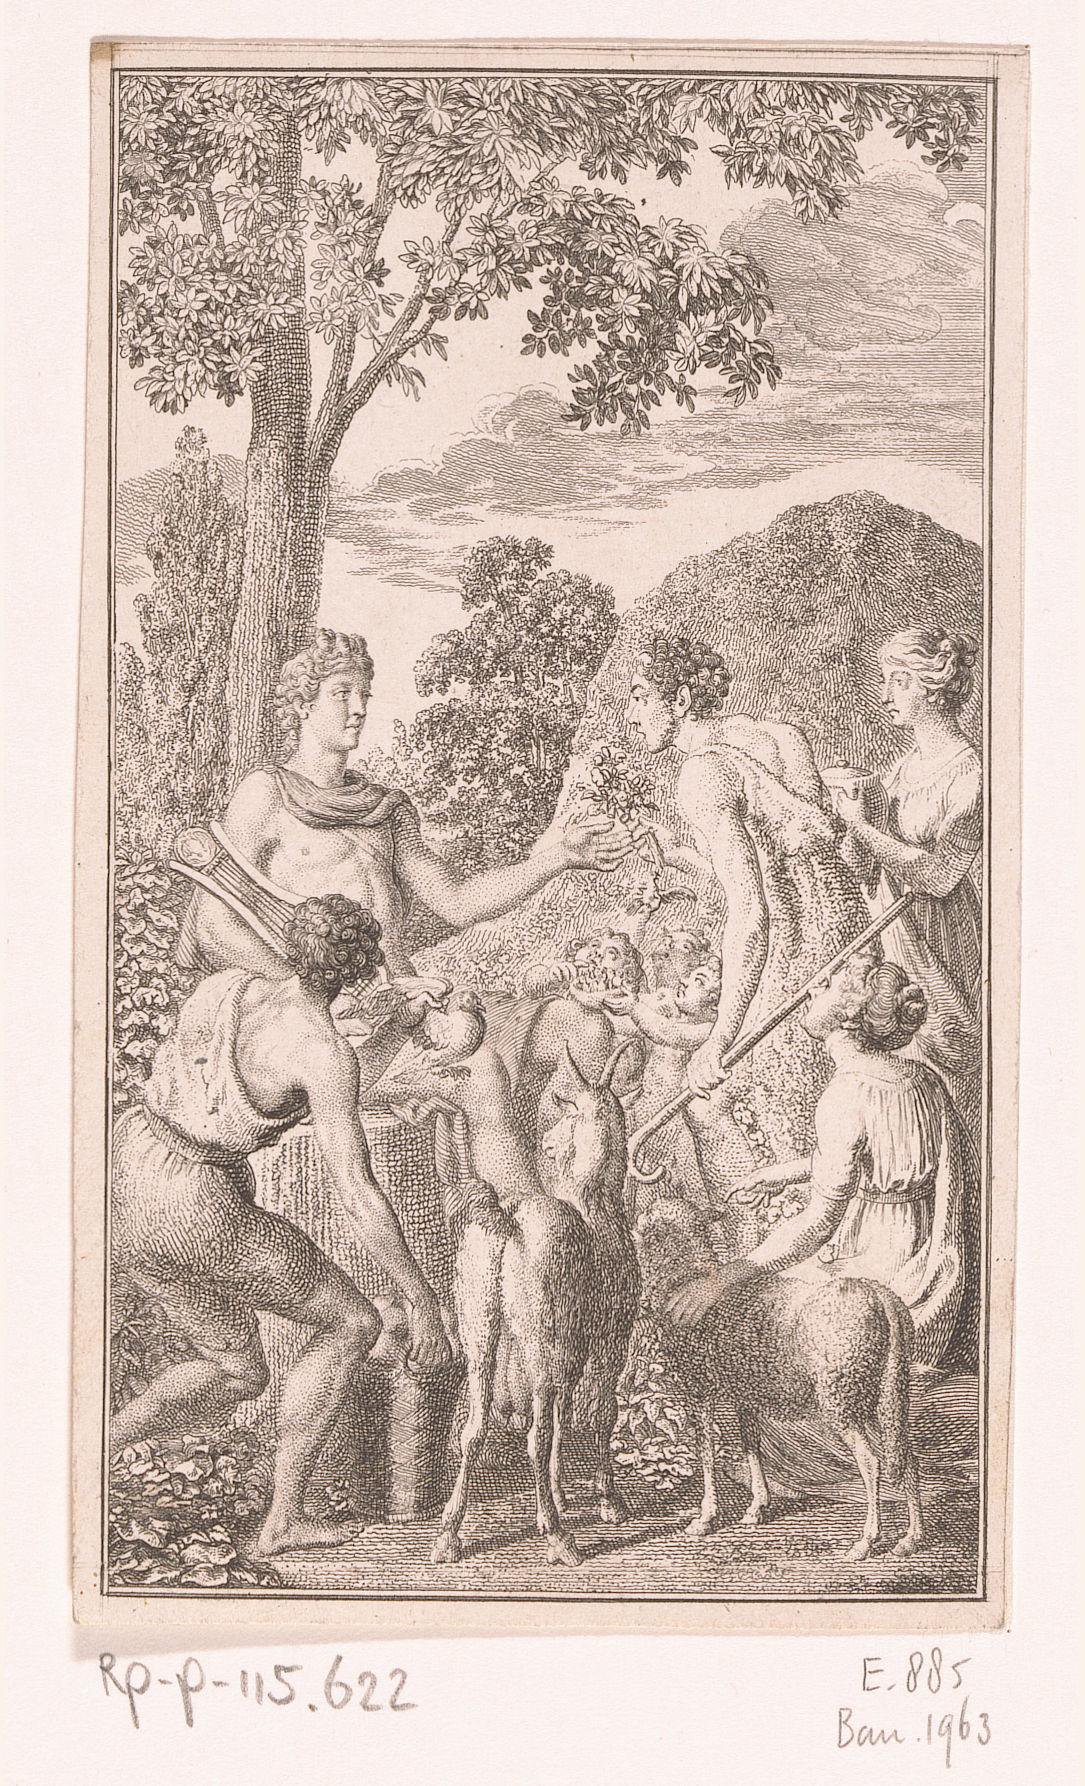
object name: print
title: Herders brengen Apollo geschenken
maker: daniel nikolaus chodowiecki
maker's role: draughtsman, print maker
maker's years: 1726-1801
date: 1798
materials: paper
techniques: etching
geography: berlin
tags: attributes of apollo: lyre, (story of) apollo (phoebus), herding, herdsman, herdswoman, shepherd, shepherdess, cowherd, etc., bringing gifts; exchanging gifts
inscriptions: collector's mark: Lugt 2228